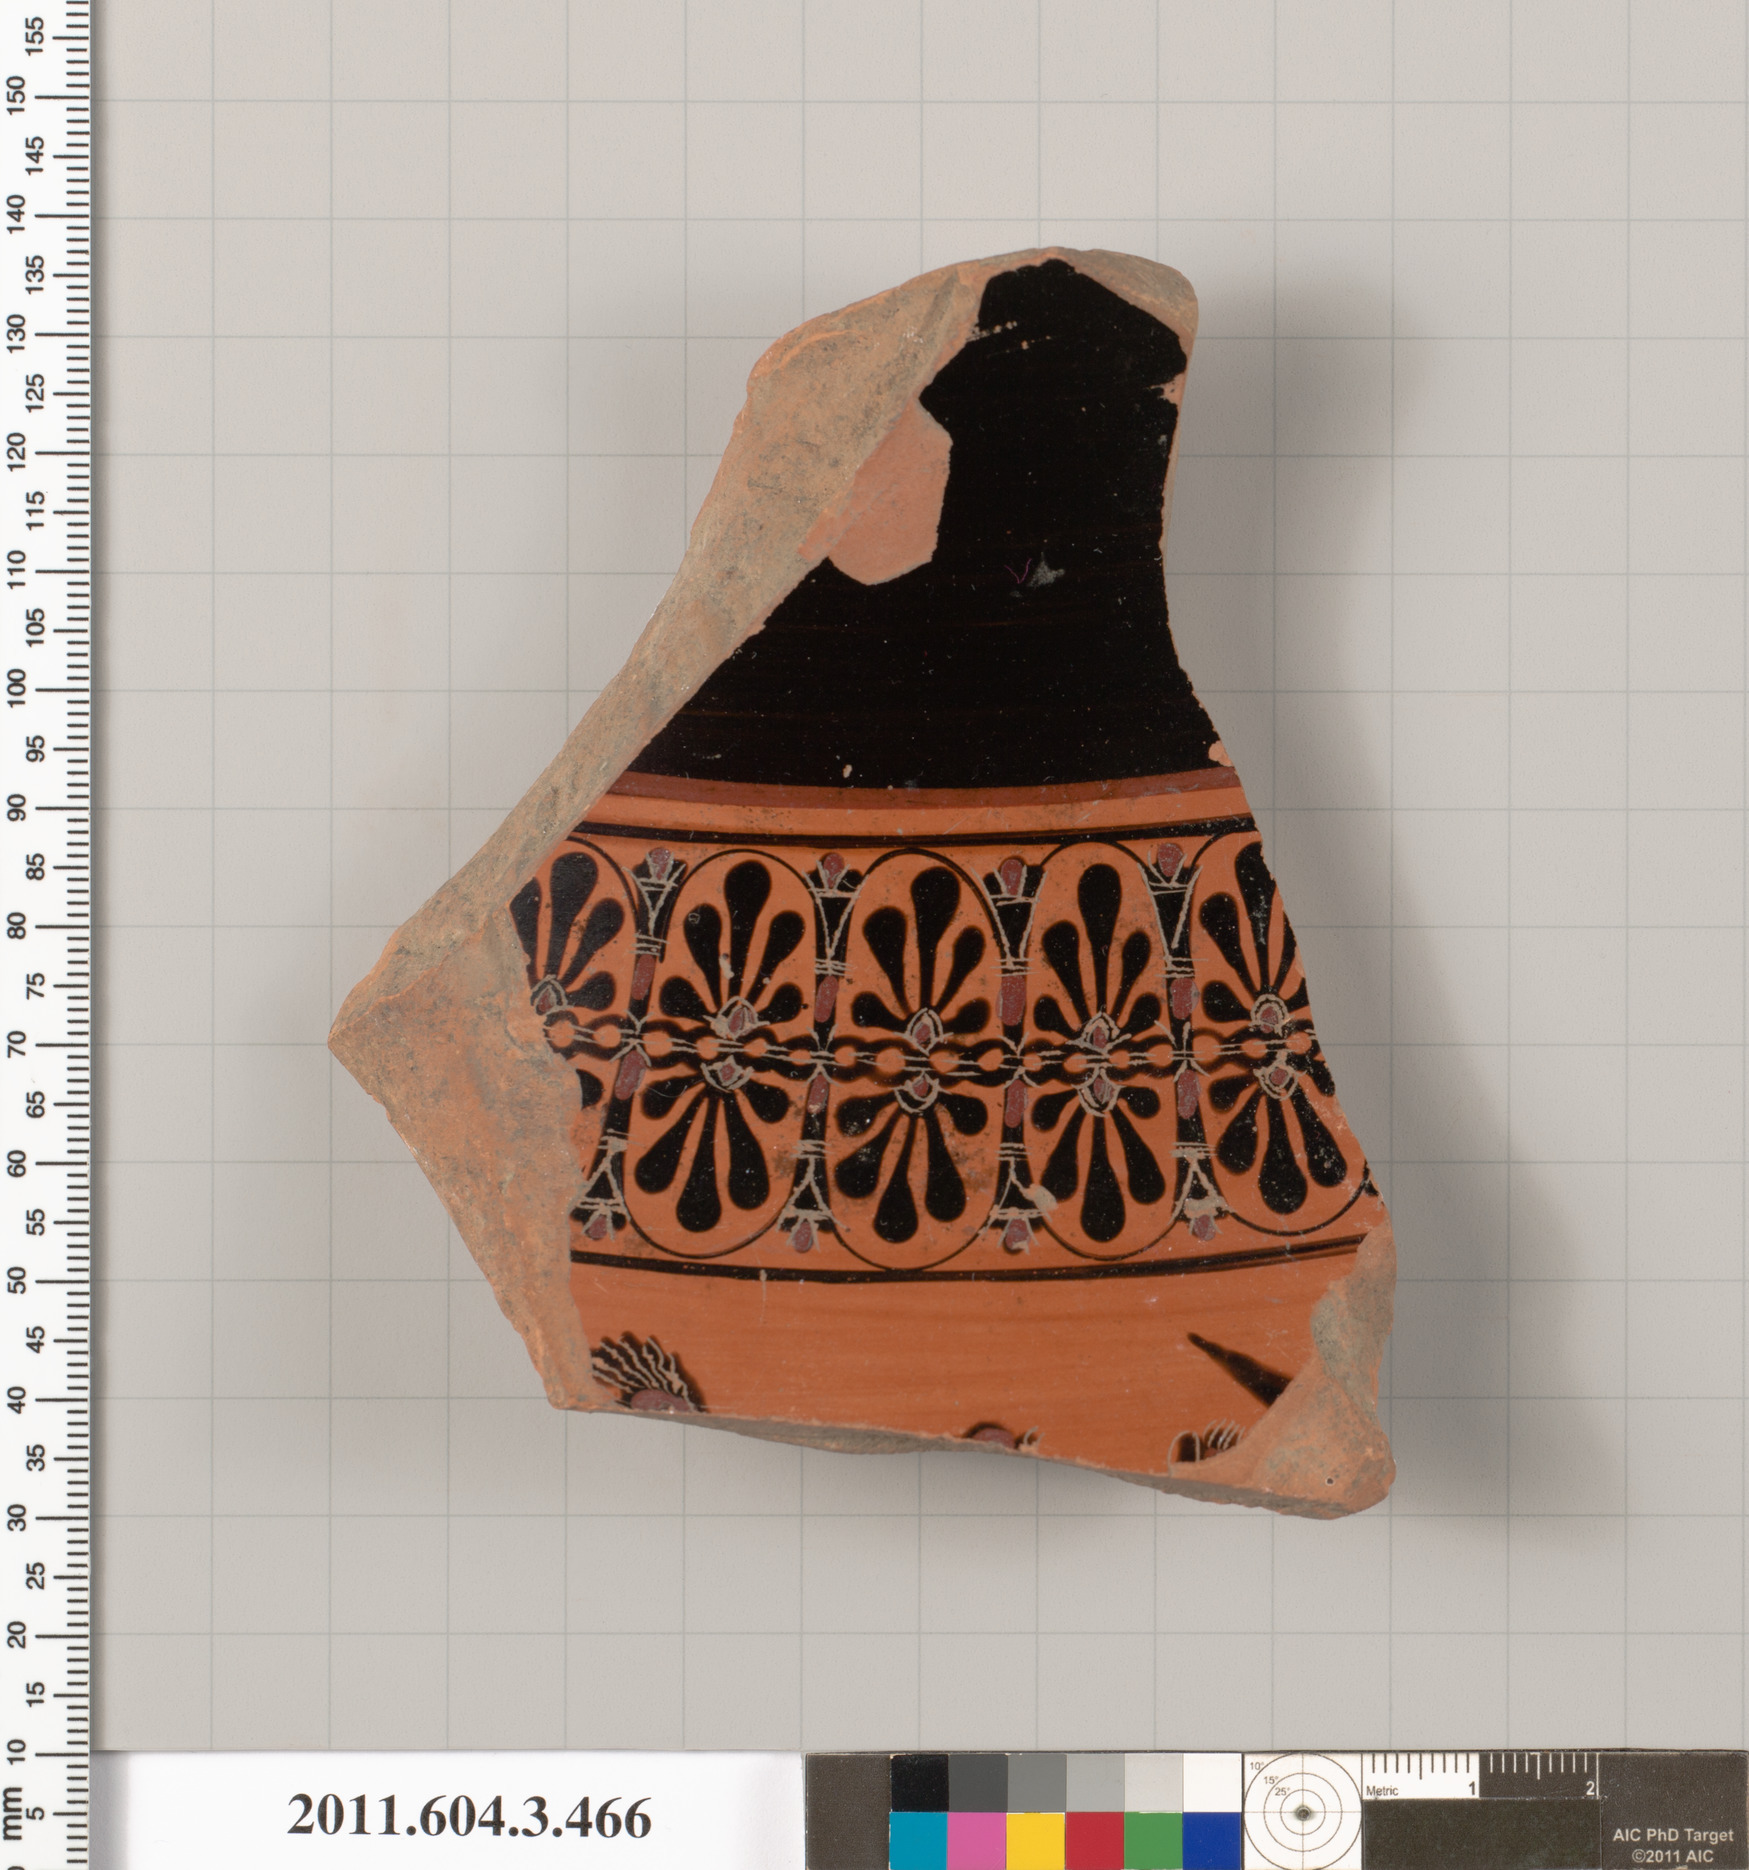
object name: amphora fragment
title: Terracotta fragment of an amphora (jar)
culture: greek, attic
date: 550-526 BCE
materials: terracotta